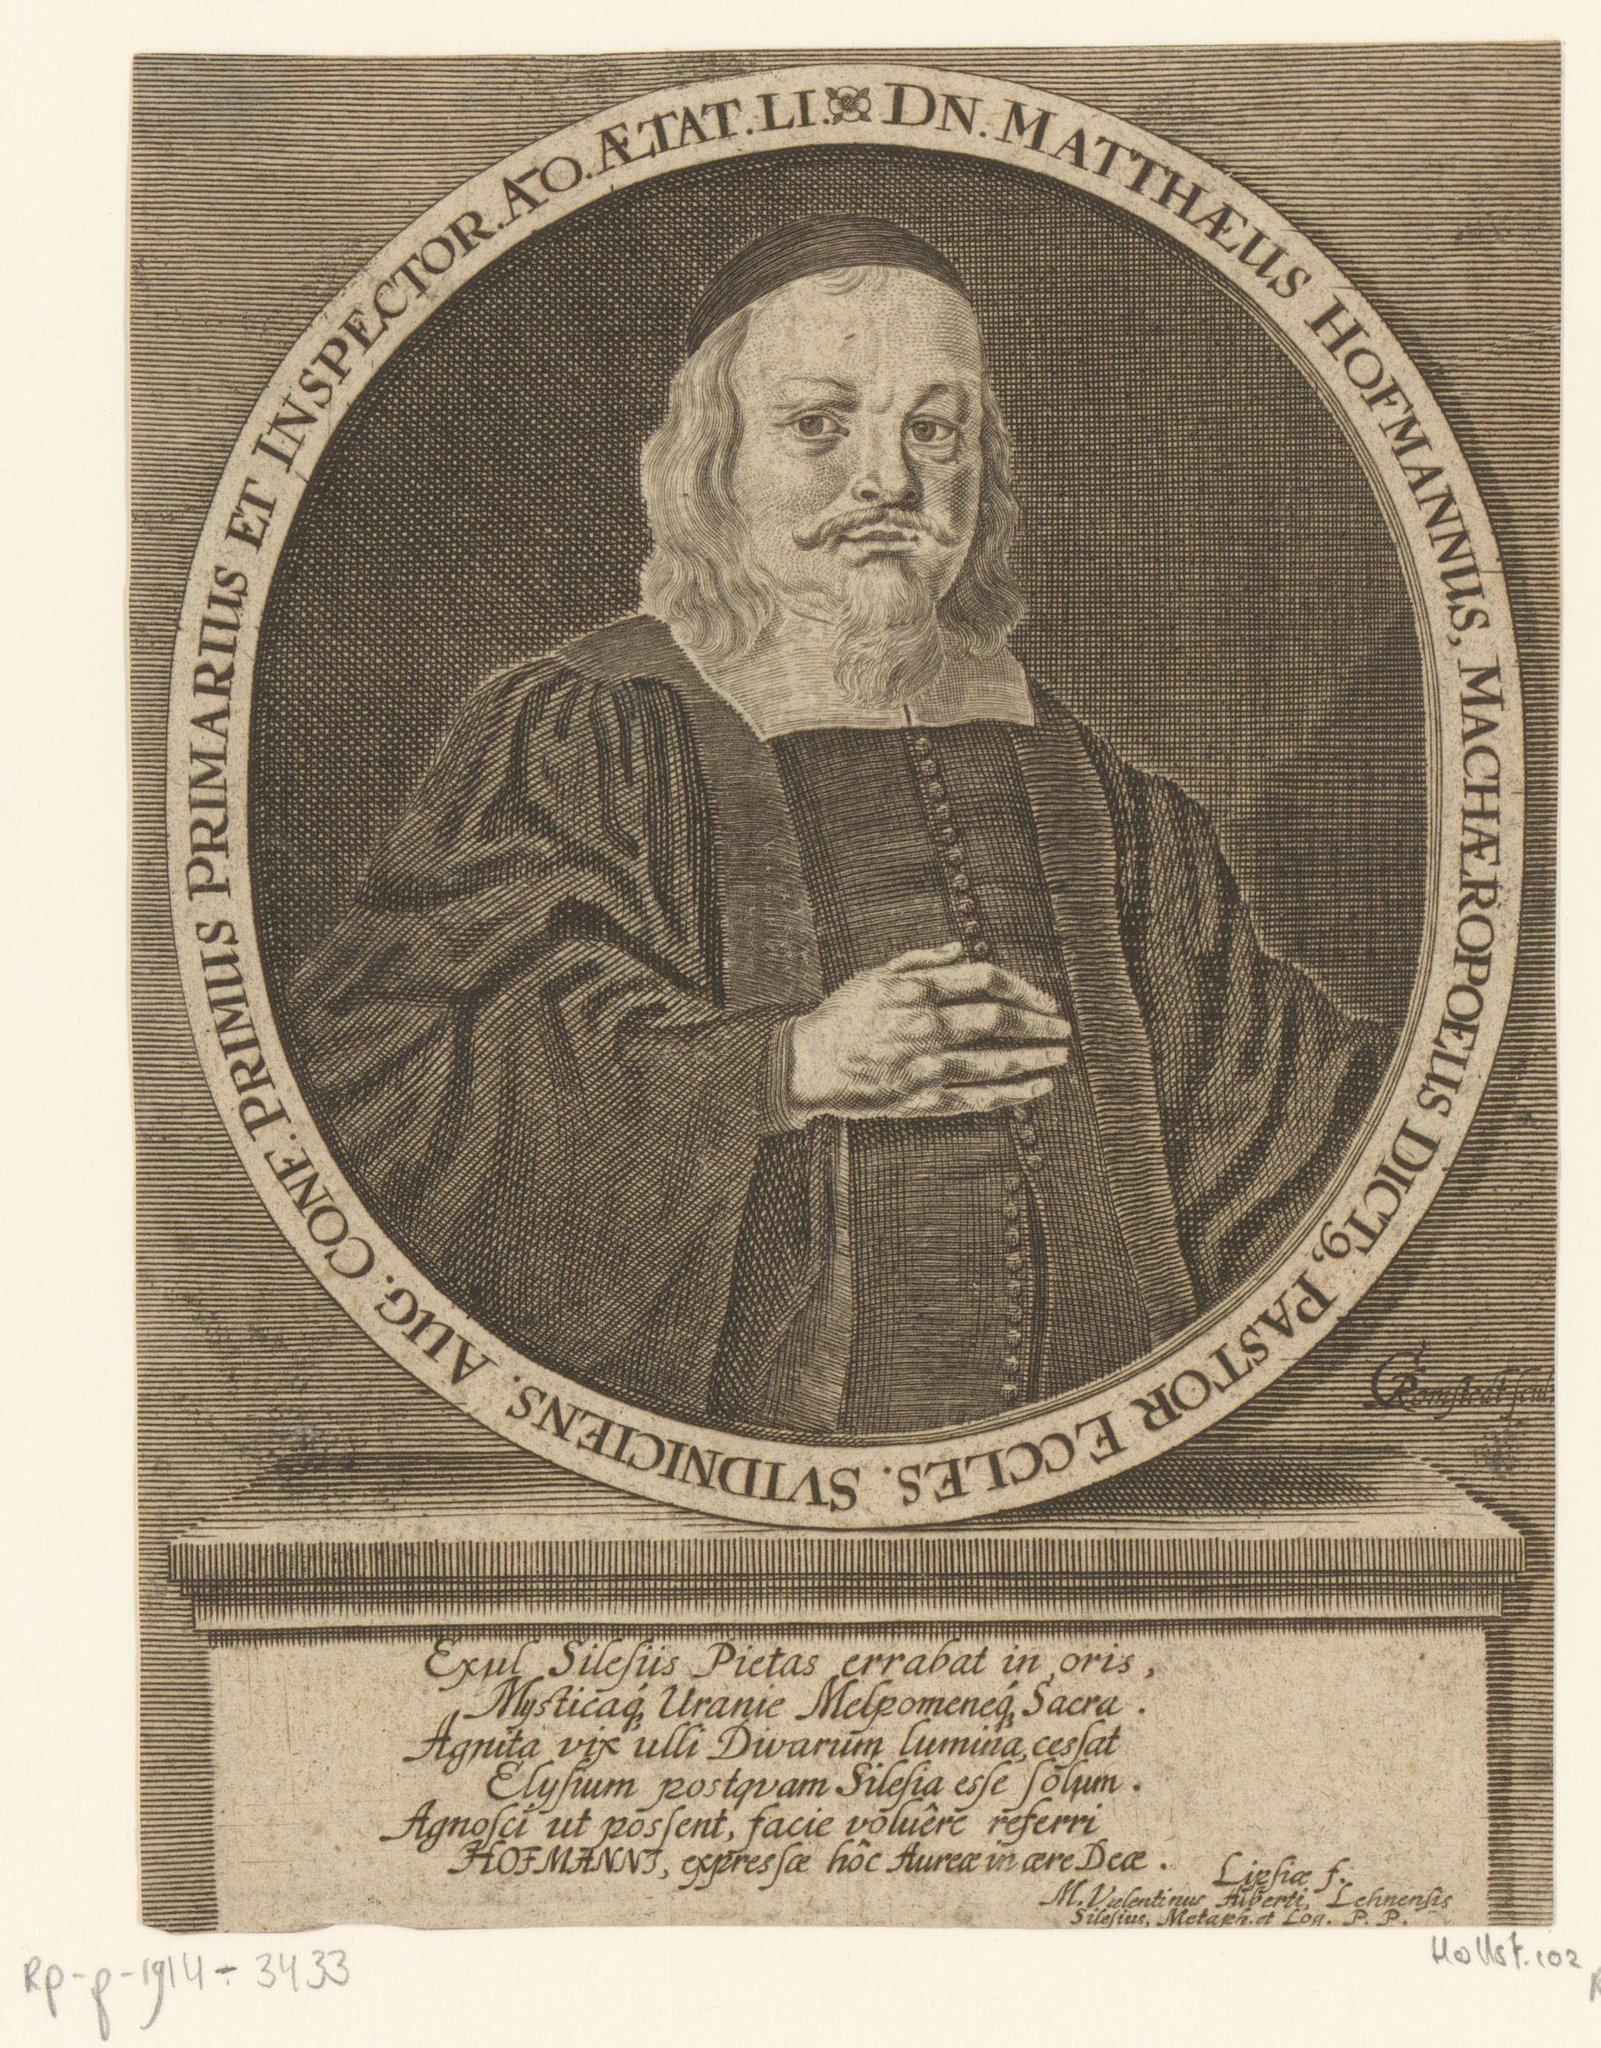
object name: print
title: Portret van Matthäus Hofmann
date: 1665-1721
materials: paper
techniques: engraving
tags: theologian, historical persons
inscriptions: collector's mark: Lugt 2228